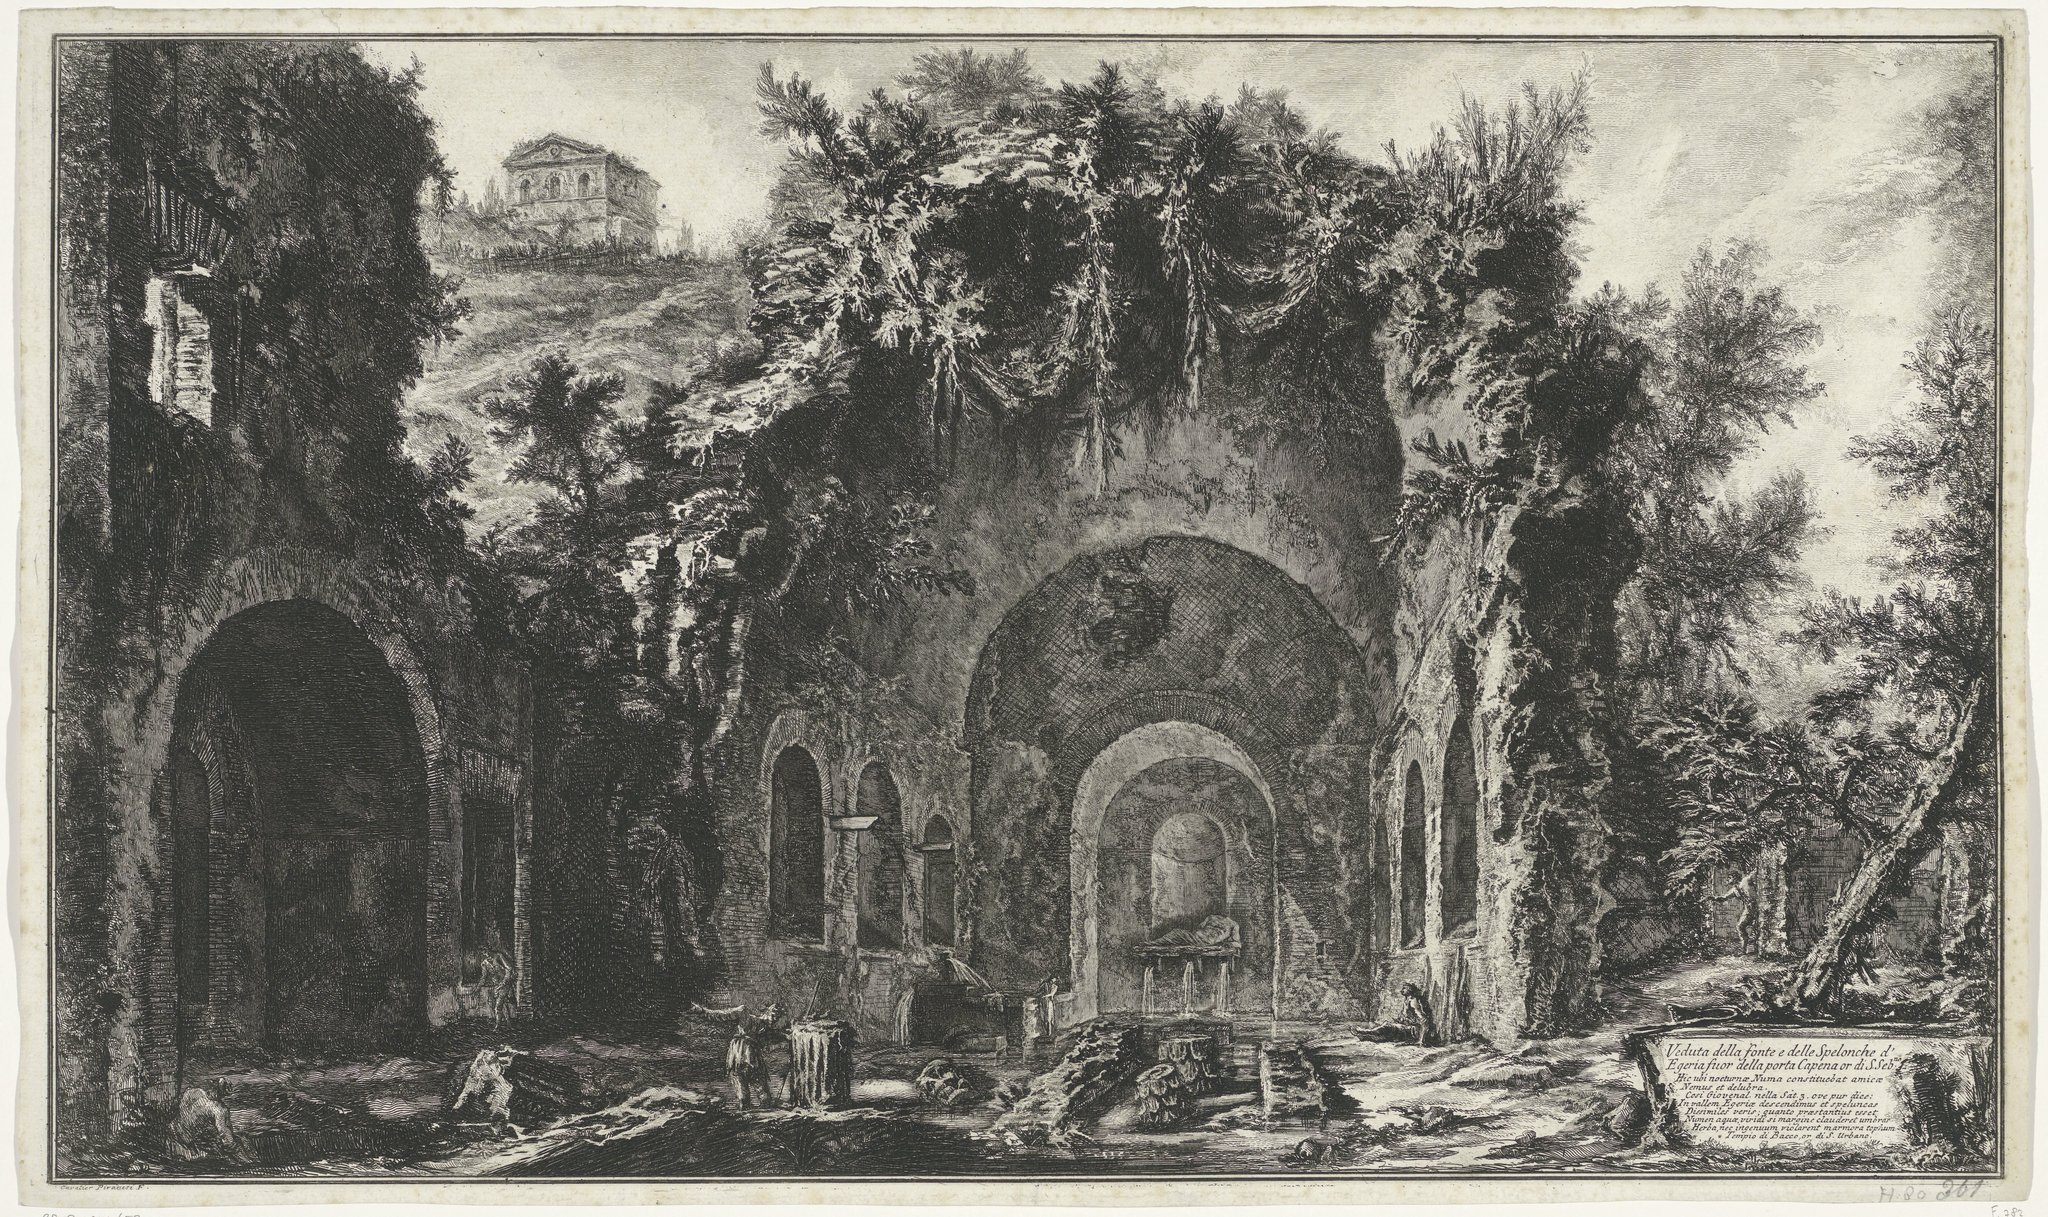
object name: print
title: Veduta della fonte e delle Spelonche d'Egeria fuor della porta Capena or di S. Seb.n (...)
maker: giovanni battista piranesi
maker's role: designer, draughtsman, print maker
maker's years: 1720-1778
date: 1748-1778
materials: paper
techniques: etching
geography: rome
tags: city-view, and landscape with man-made constructions, ruin of a building ~ architecture, landscape with ruins, rome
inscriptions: collector's mark: Lugt 2228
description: Deze prent maakt deel uit van de serie 'Vedute di Roma'. Piranesi werkte aan deze 135 platen tellende serie tussen 1748 en zijn dood in 1778. Francesco Piranesi voegde later nog twee prenten toe aan de reeks van zijn vader.